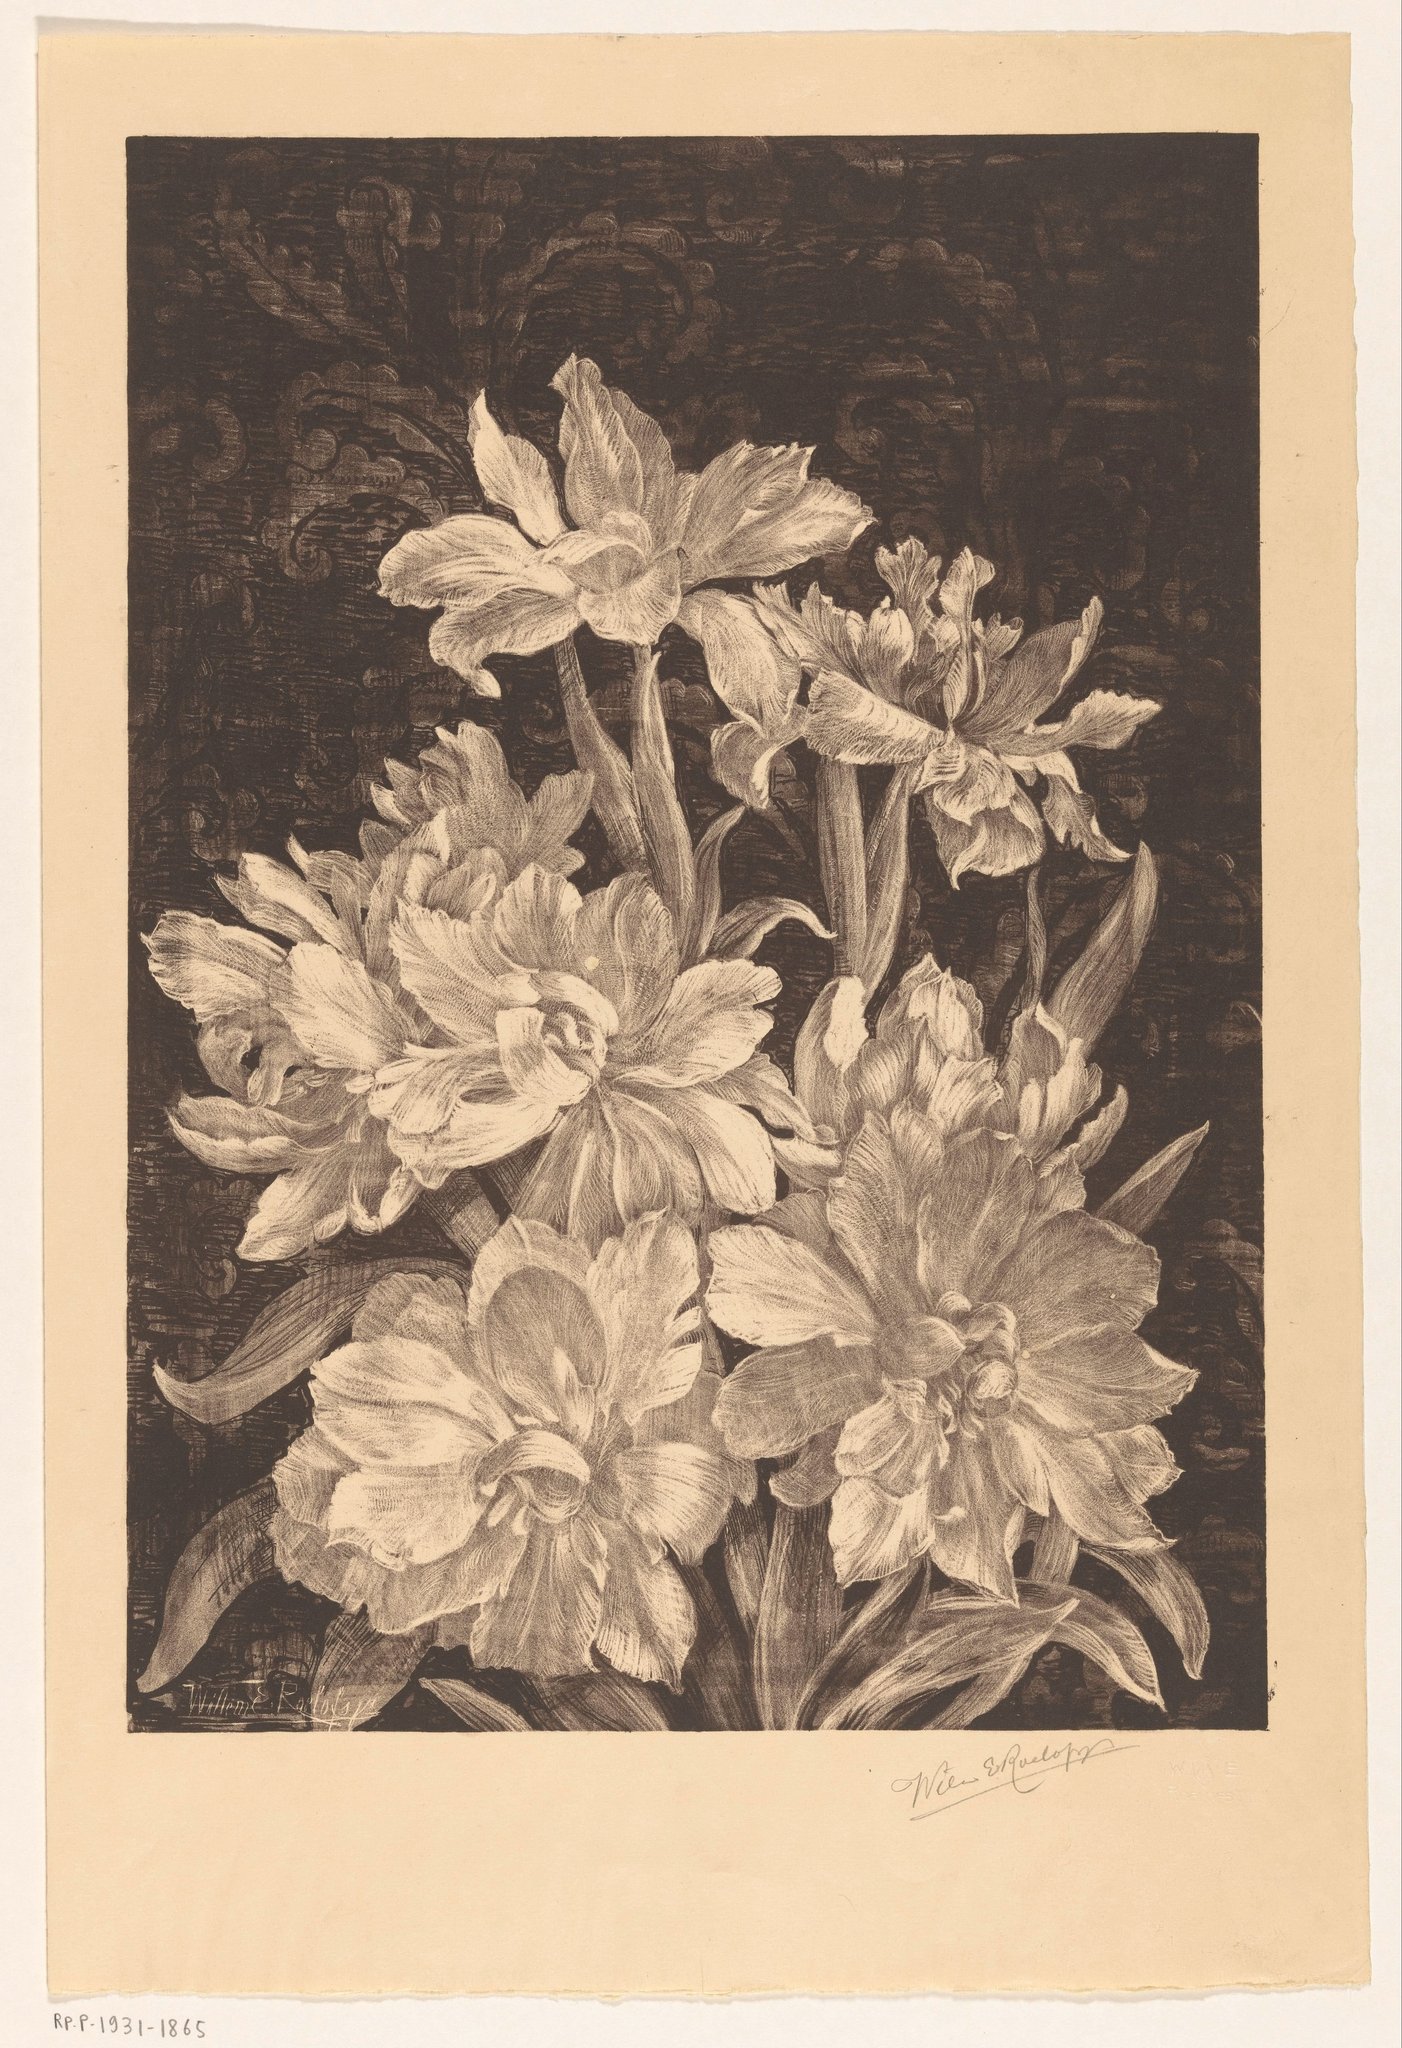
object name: print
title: Tulpen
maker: willem roelofs (ii)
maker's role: draughtsman, painter, print maker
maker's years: 1874-1940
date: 1884-1931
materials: paper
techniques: lithograph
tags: flowers: tulip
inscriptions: collector's mark: Lugt 2228, number: ‘15’